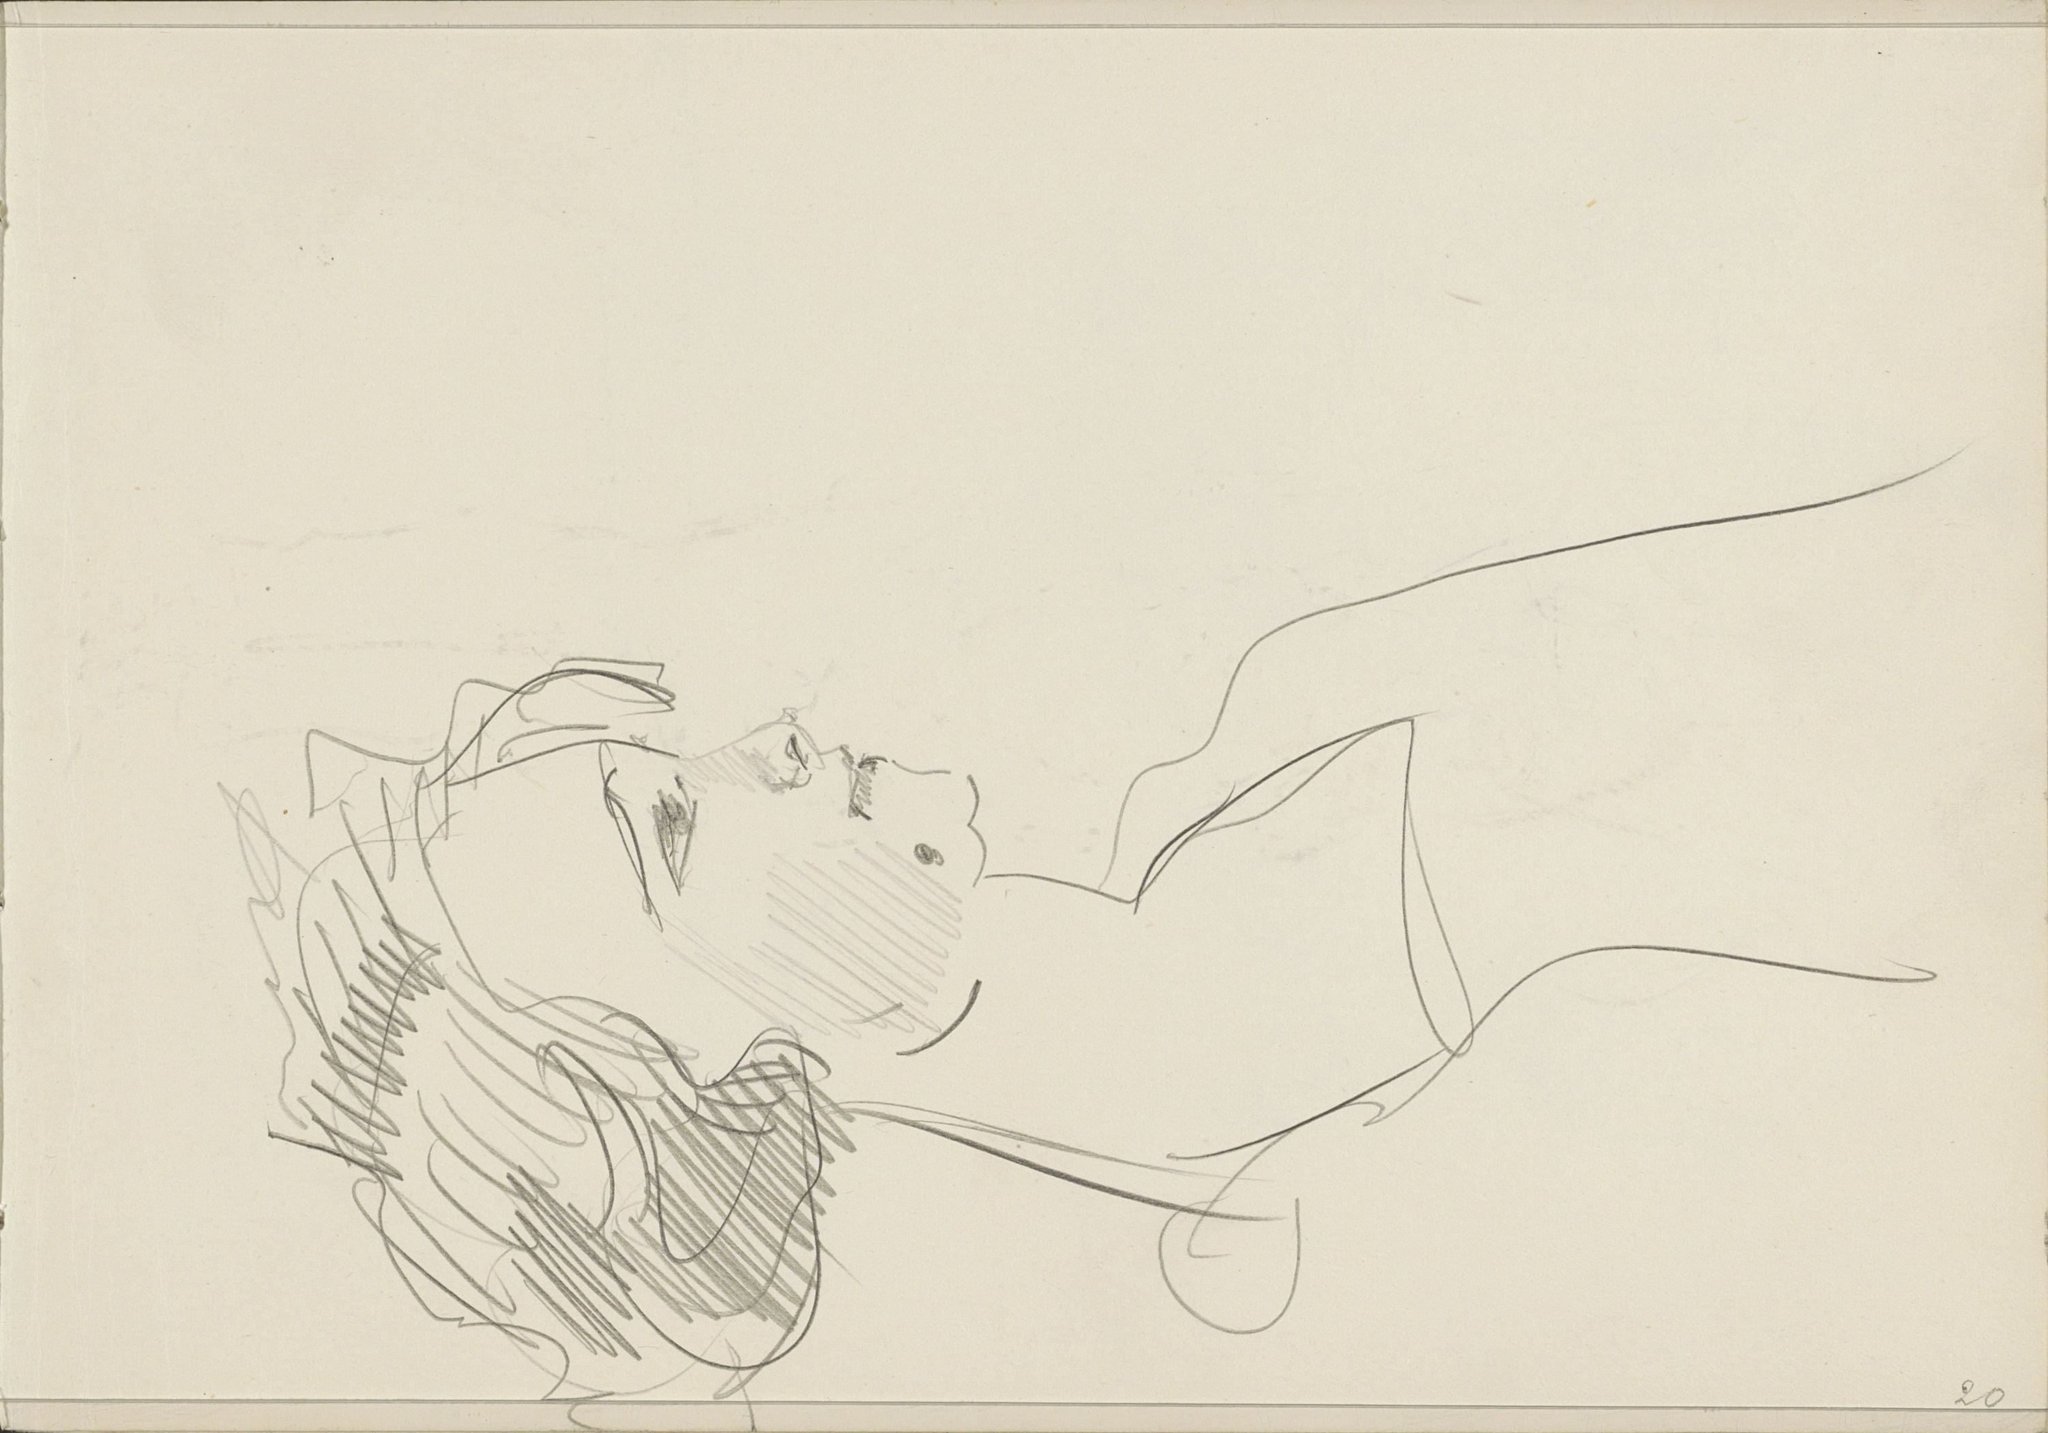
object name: sketchbook leaf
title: Vrouw, in profiel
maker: isaac israels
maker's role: draughtsman, painter, print maker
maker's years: 1865-1934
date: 1915-1934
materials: paper, pencil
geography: the hague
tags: adult woman (+ sideview, profile)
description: Blad 20 recto uit schetsboek XXV met 23 bladen.